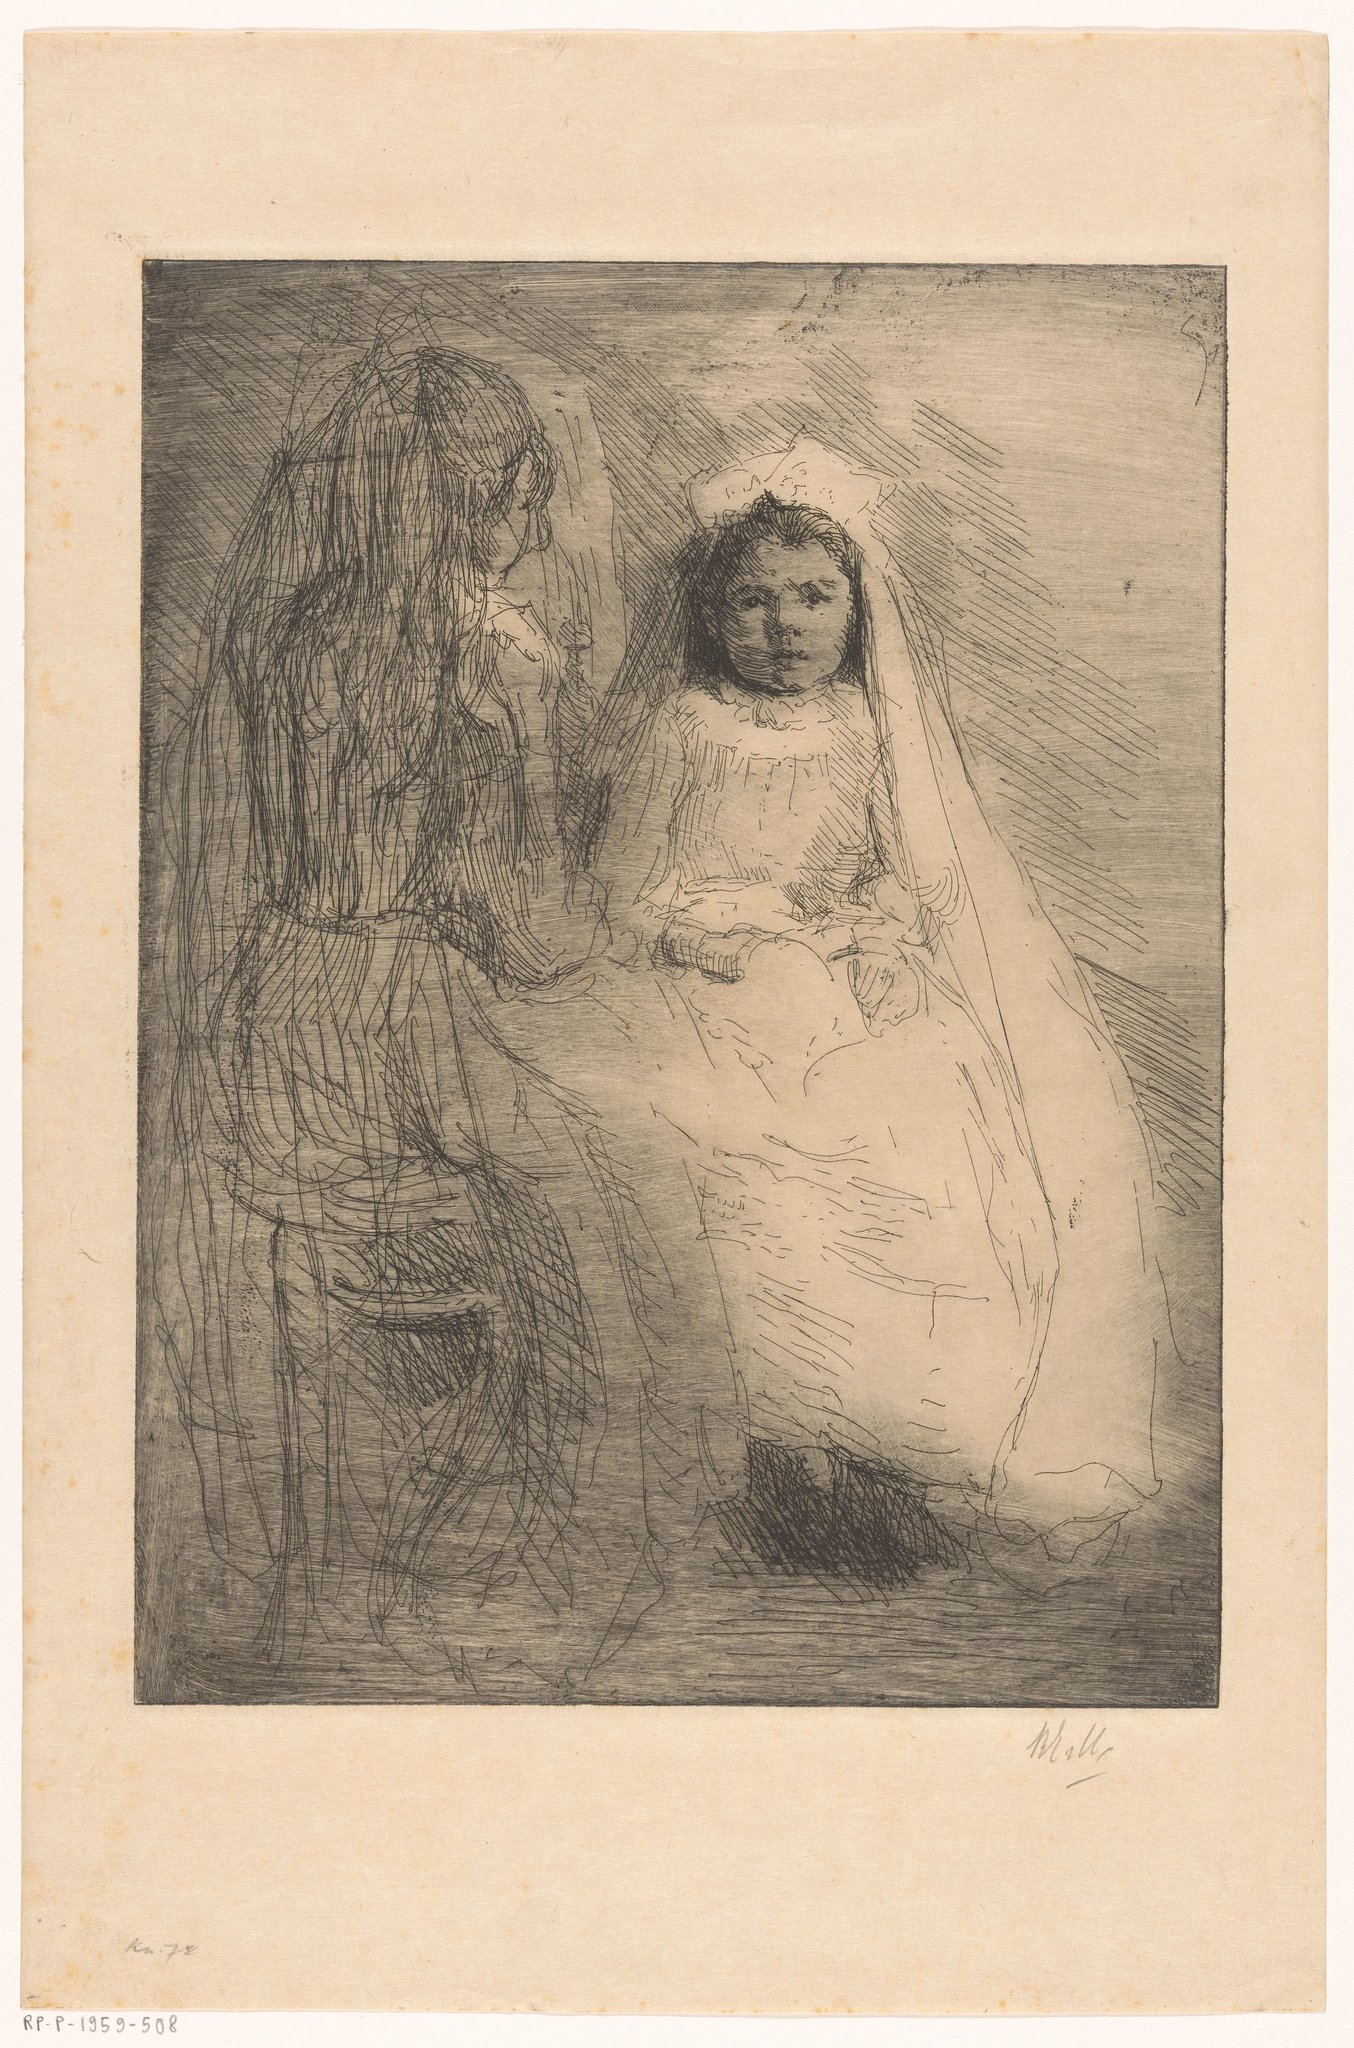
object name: print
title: Twee meisjes in bruidskleding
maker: barbara elisabeth van houten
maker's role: draughtsman, print maker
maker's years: 1862-1950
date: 1872-1950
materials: paper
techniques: etching, intaglio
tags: bridesmaid, girl (child between toddler and youth)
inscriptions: collector's mark: Lugt 2228